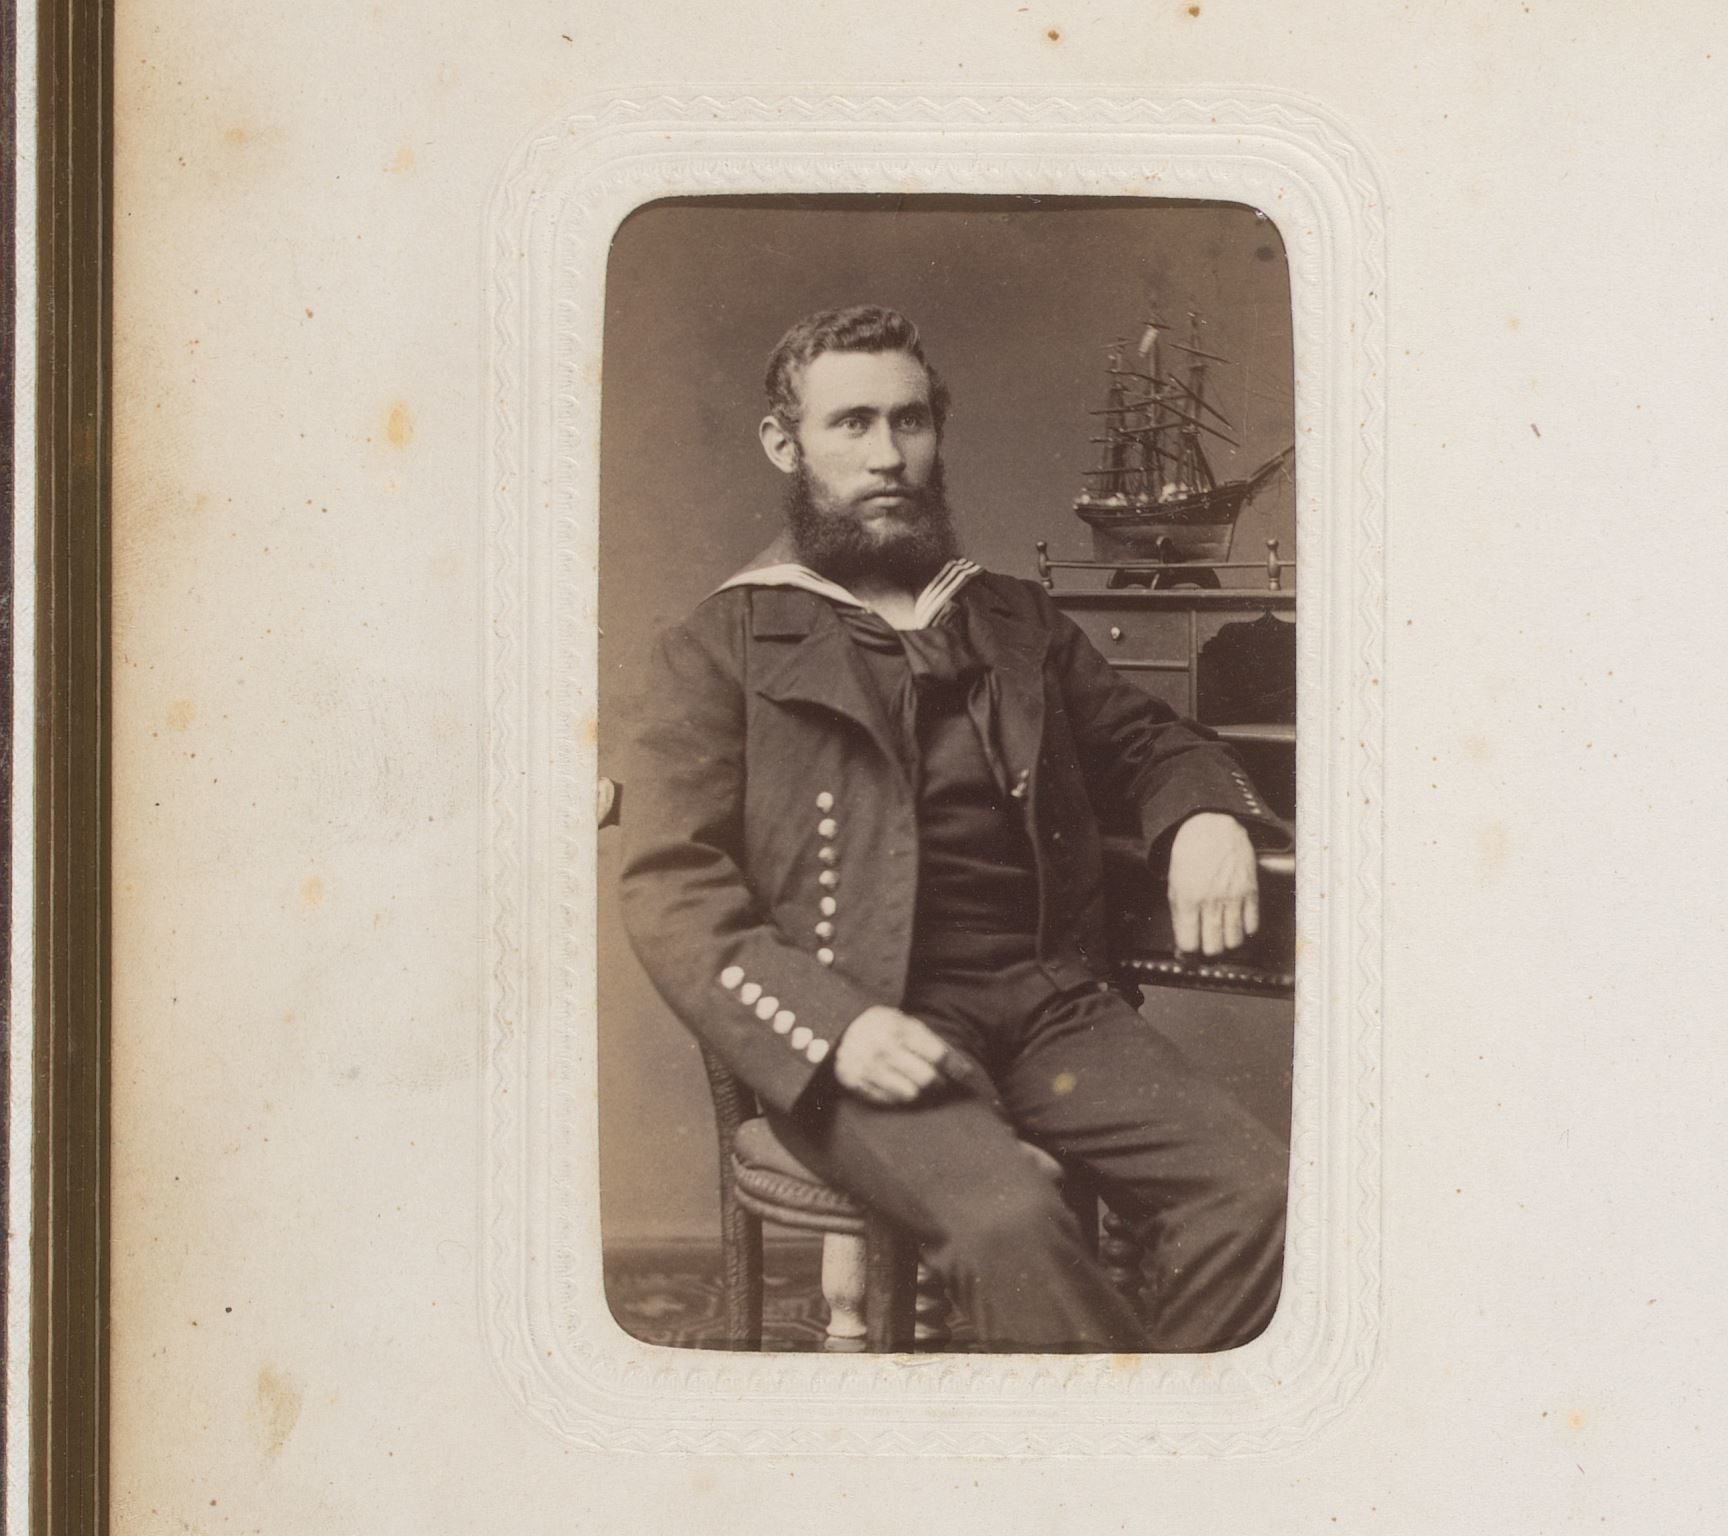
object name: carte de visite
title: Portret van een zittende man in nautisch uniform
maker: c.j. frankforth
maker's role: fotograaf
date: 1850-1900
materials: cardboard, photographic support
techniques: albumen print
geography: wilhelmshaven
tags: sitting figure, (military) uniforms (+ naval force), historical persons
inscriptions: inscription: ‘C. J. FRANKFORTH/ Photograph/ in/ WILHELMSHAVEN/ Platte wirdzu Nachbestellungen aufbewahrt.’